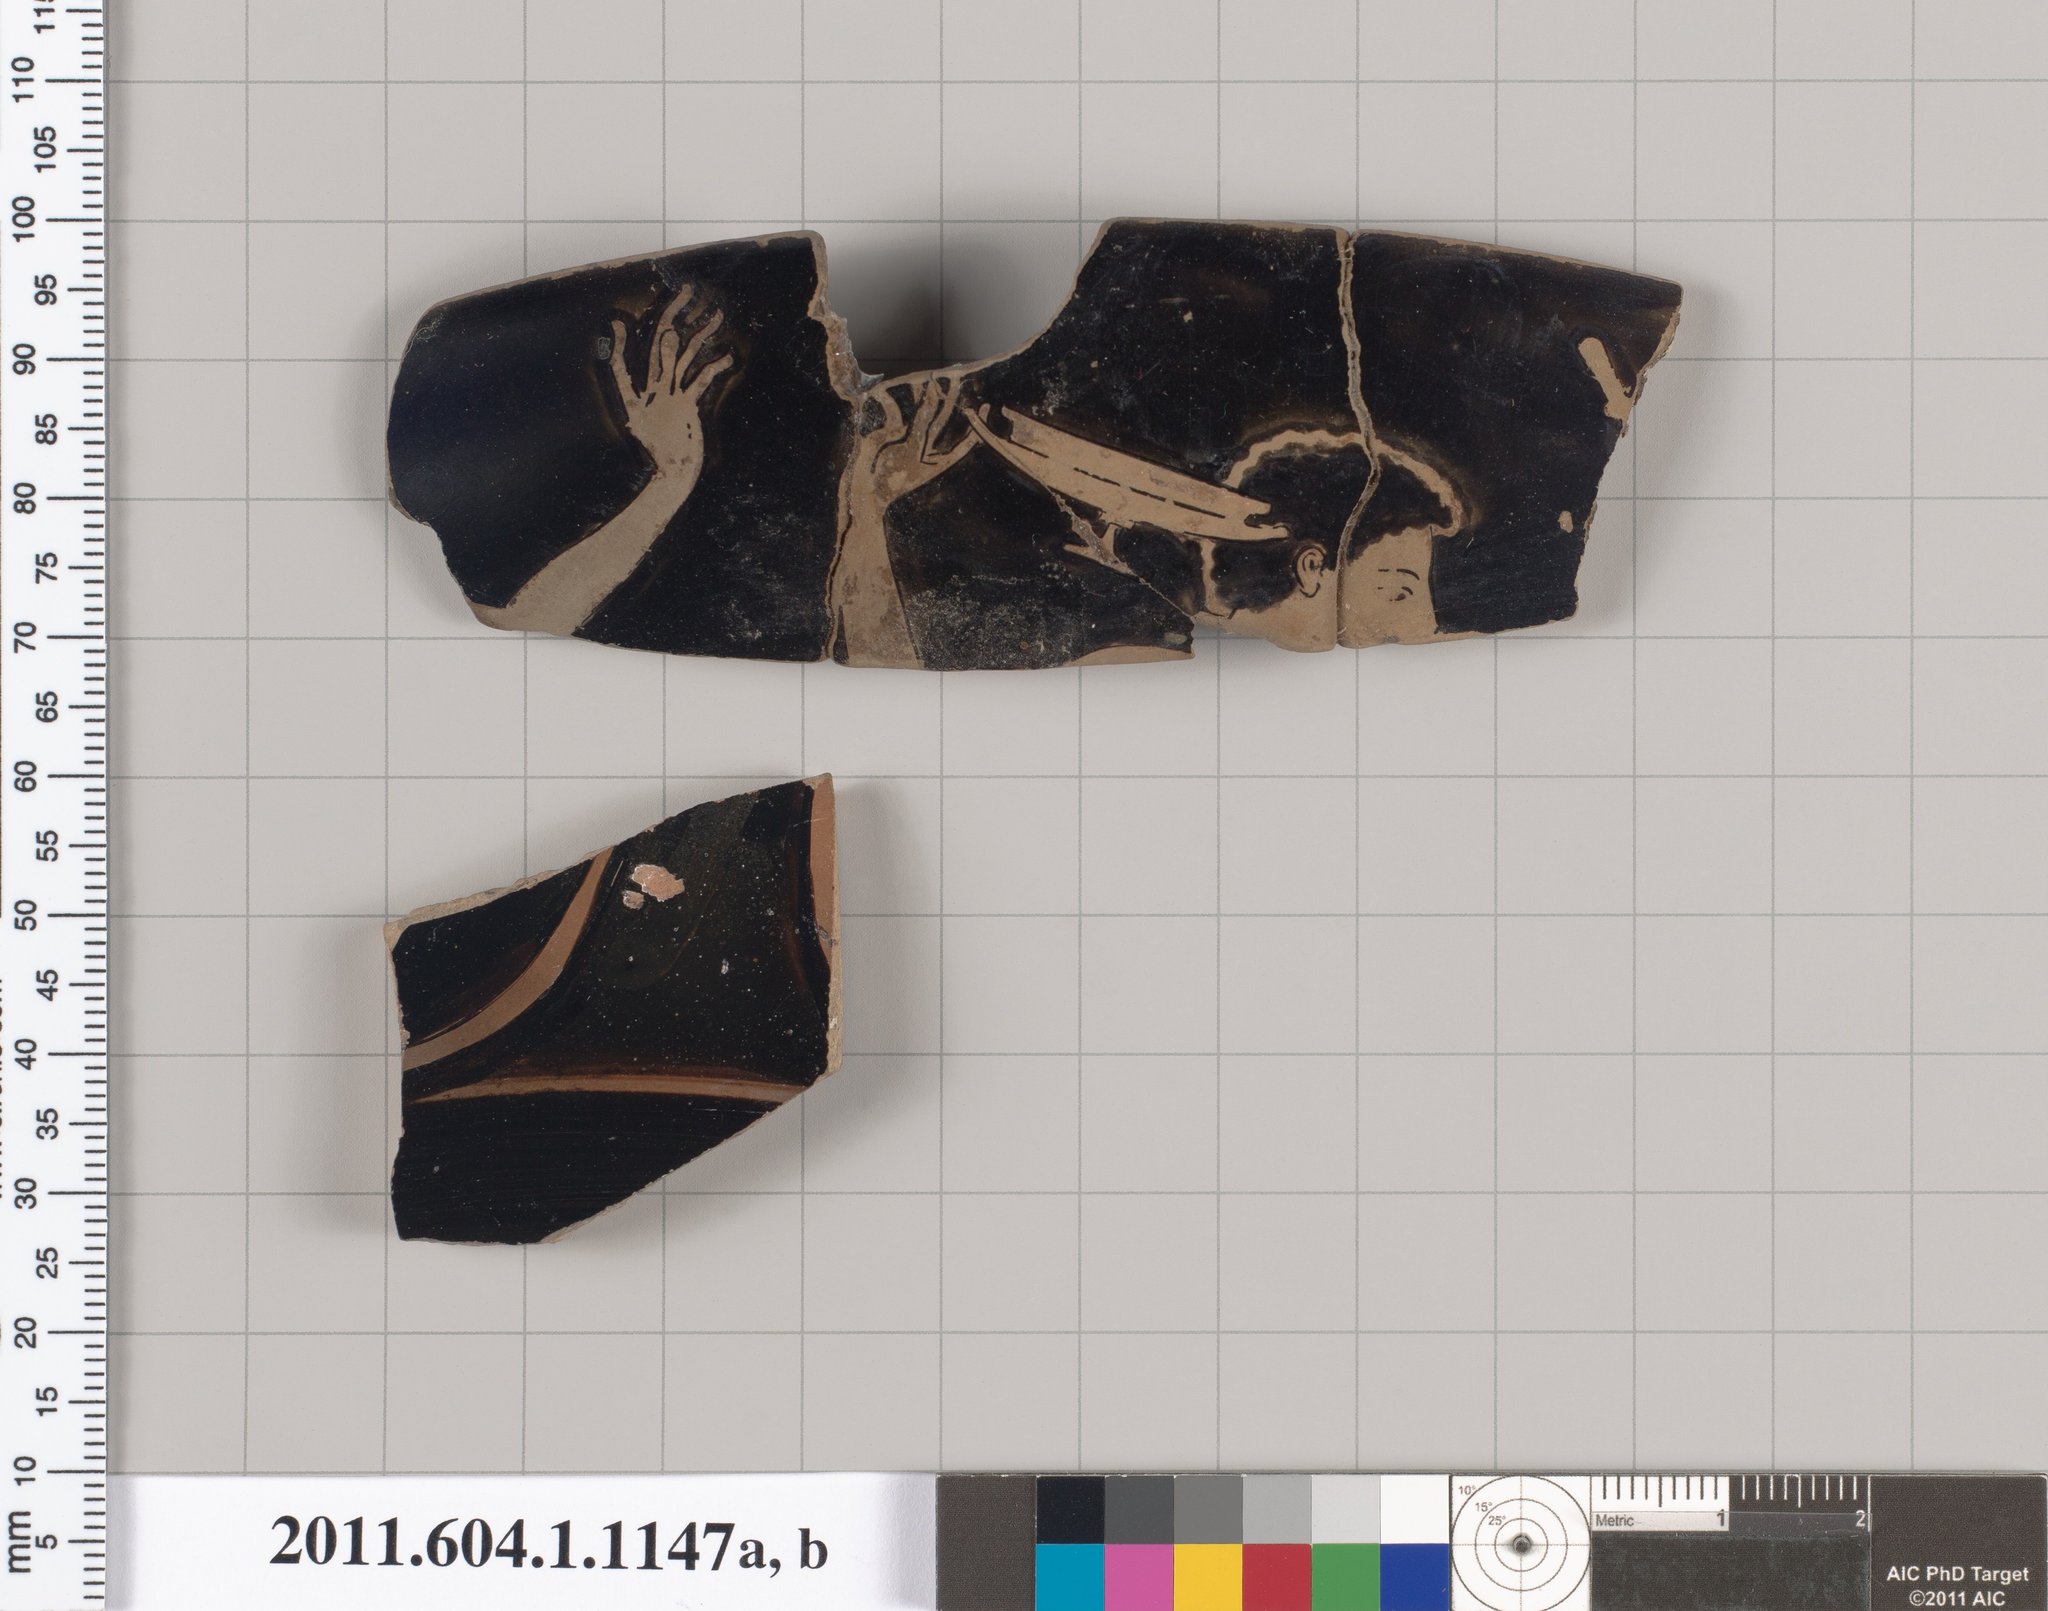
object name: kylix fragment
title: Terracotta rim fragment of a kylix (drinking cup)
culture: greek, attic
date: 490 BCE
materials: terracotta